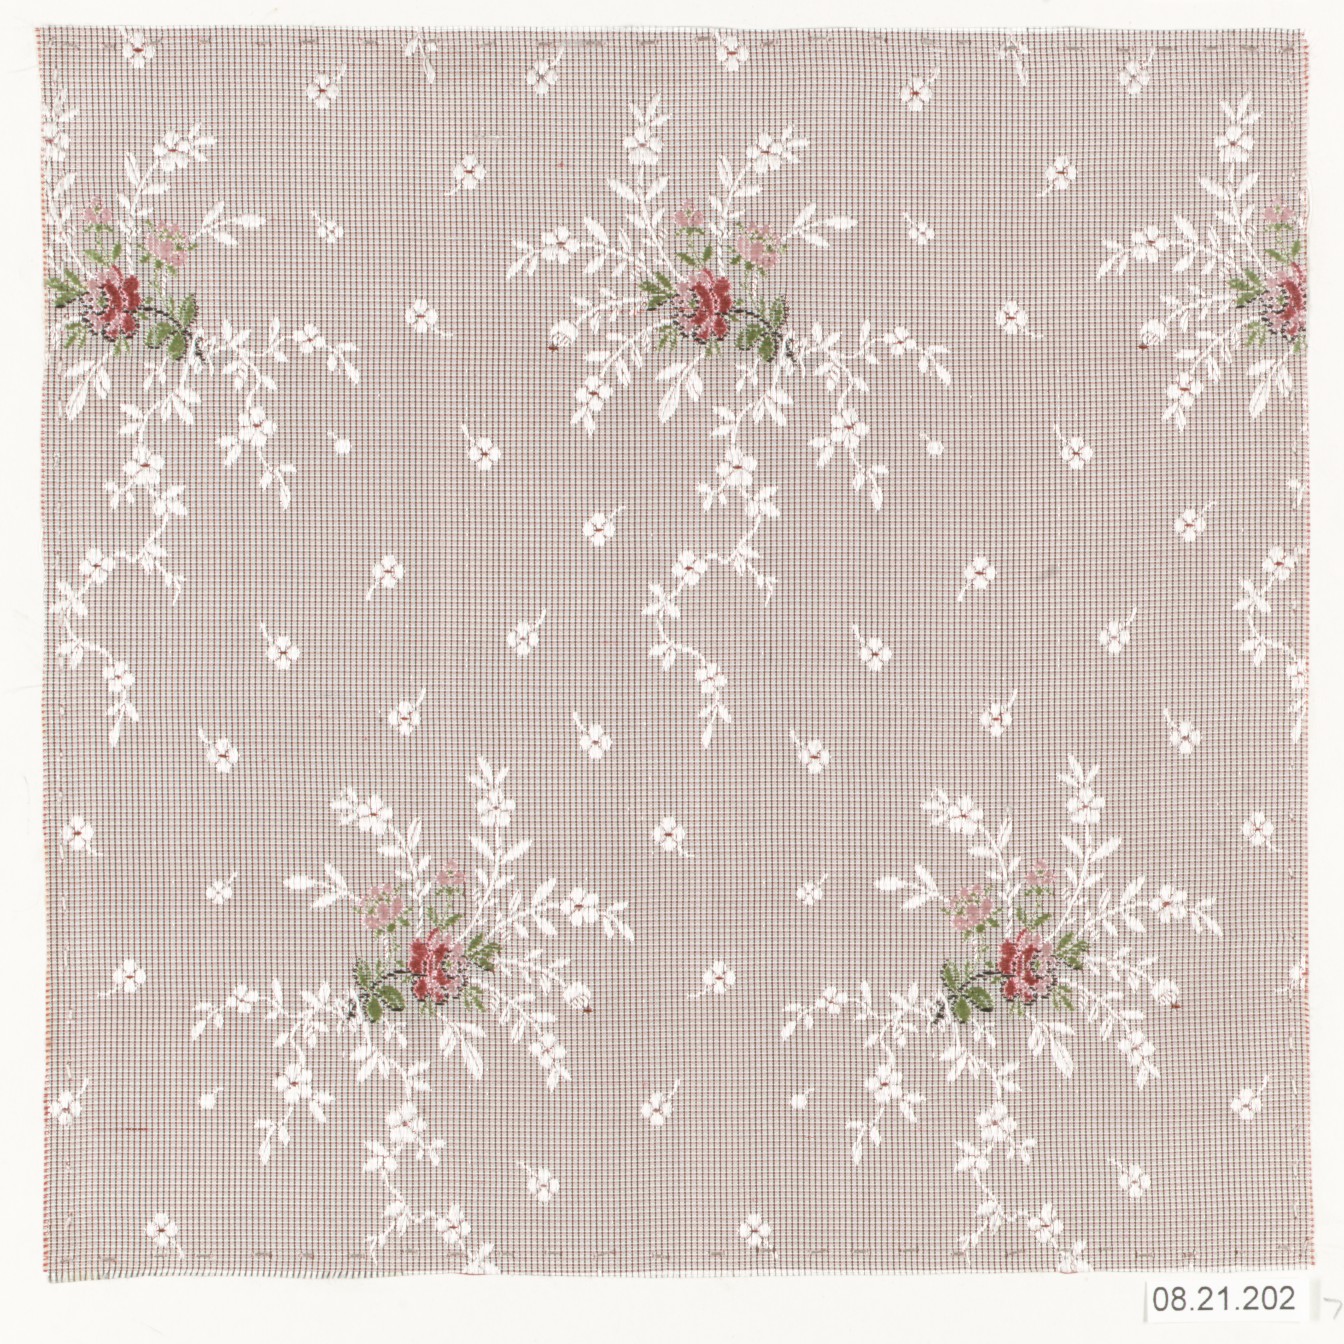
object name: textile sample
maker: Anonymous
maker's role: designer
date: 1900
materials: silk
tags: flowers